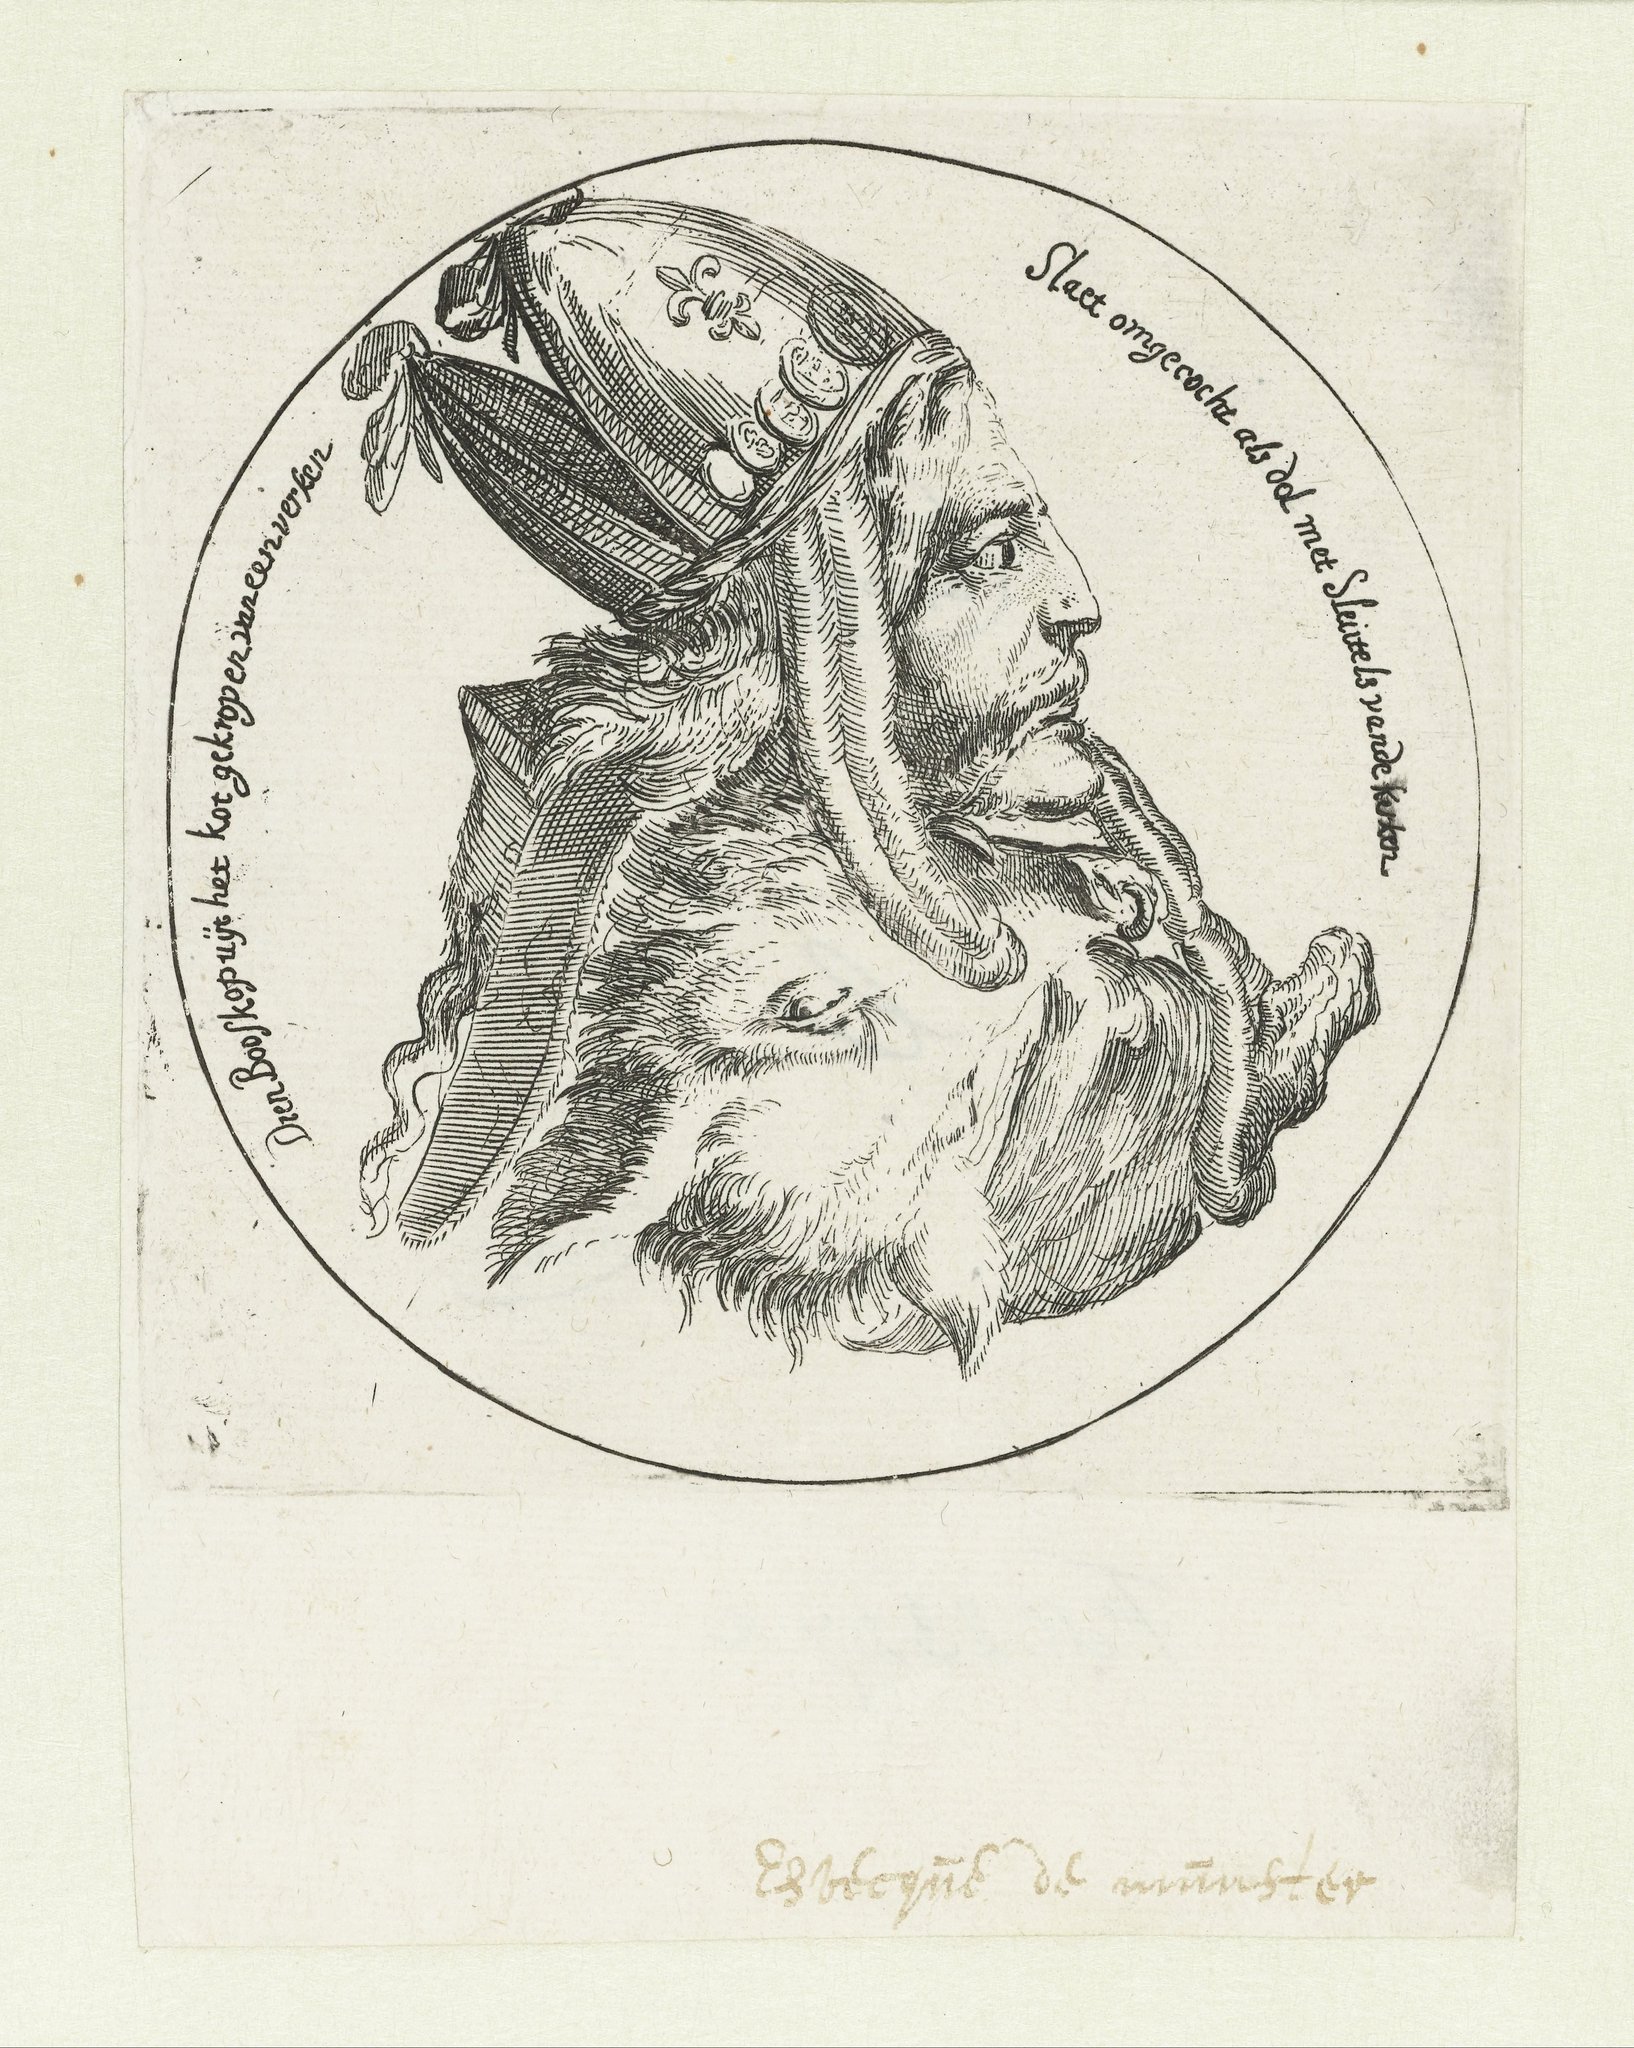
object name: print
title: Double heads of protagonists in the Year of Disasters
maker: romeyn de hooghe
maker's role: draughtsman, goldsmith, painter, print maker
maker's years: 1645-1708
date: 1672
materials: paper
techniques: etching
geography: northern netherlands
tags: rampjaar (disaster year)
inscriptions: inscription: ‘Dien booskop uijt het kot gekropen van een verken / Slaet omgecocht als dol met Sleutels van de Kerken’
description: In 1672, known as the ‘Year of Disasters’, the Dutch Republic came under simultaneous attack by France, England and Germany. The double heads depict the protagonists, whose true nature is revealed when they are turned upside down. From left to right, they are: Stadtholder William III as Mars, Louis XIV as a lion, the English King Charles II as a tiger, Archbishop Henry of Bavaria as an ass and the Bishop of Munster as a swine. Johan and Cornelis de Witt are a fox and a wolf. Many believed they were to blame for the war.